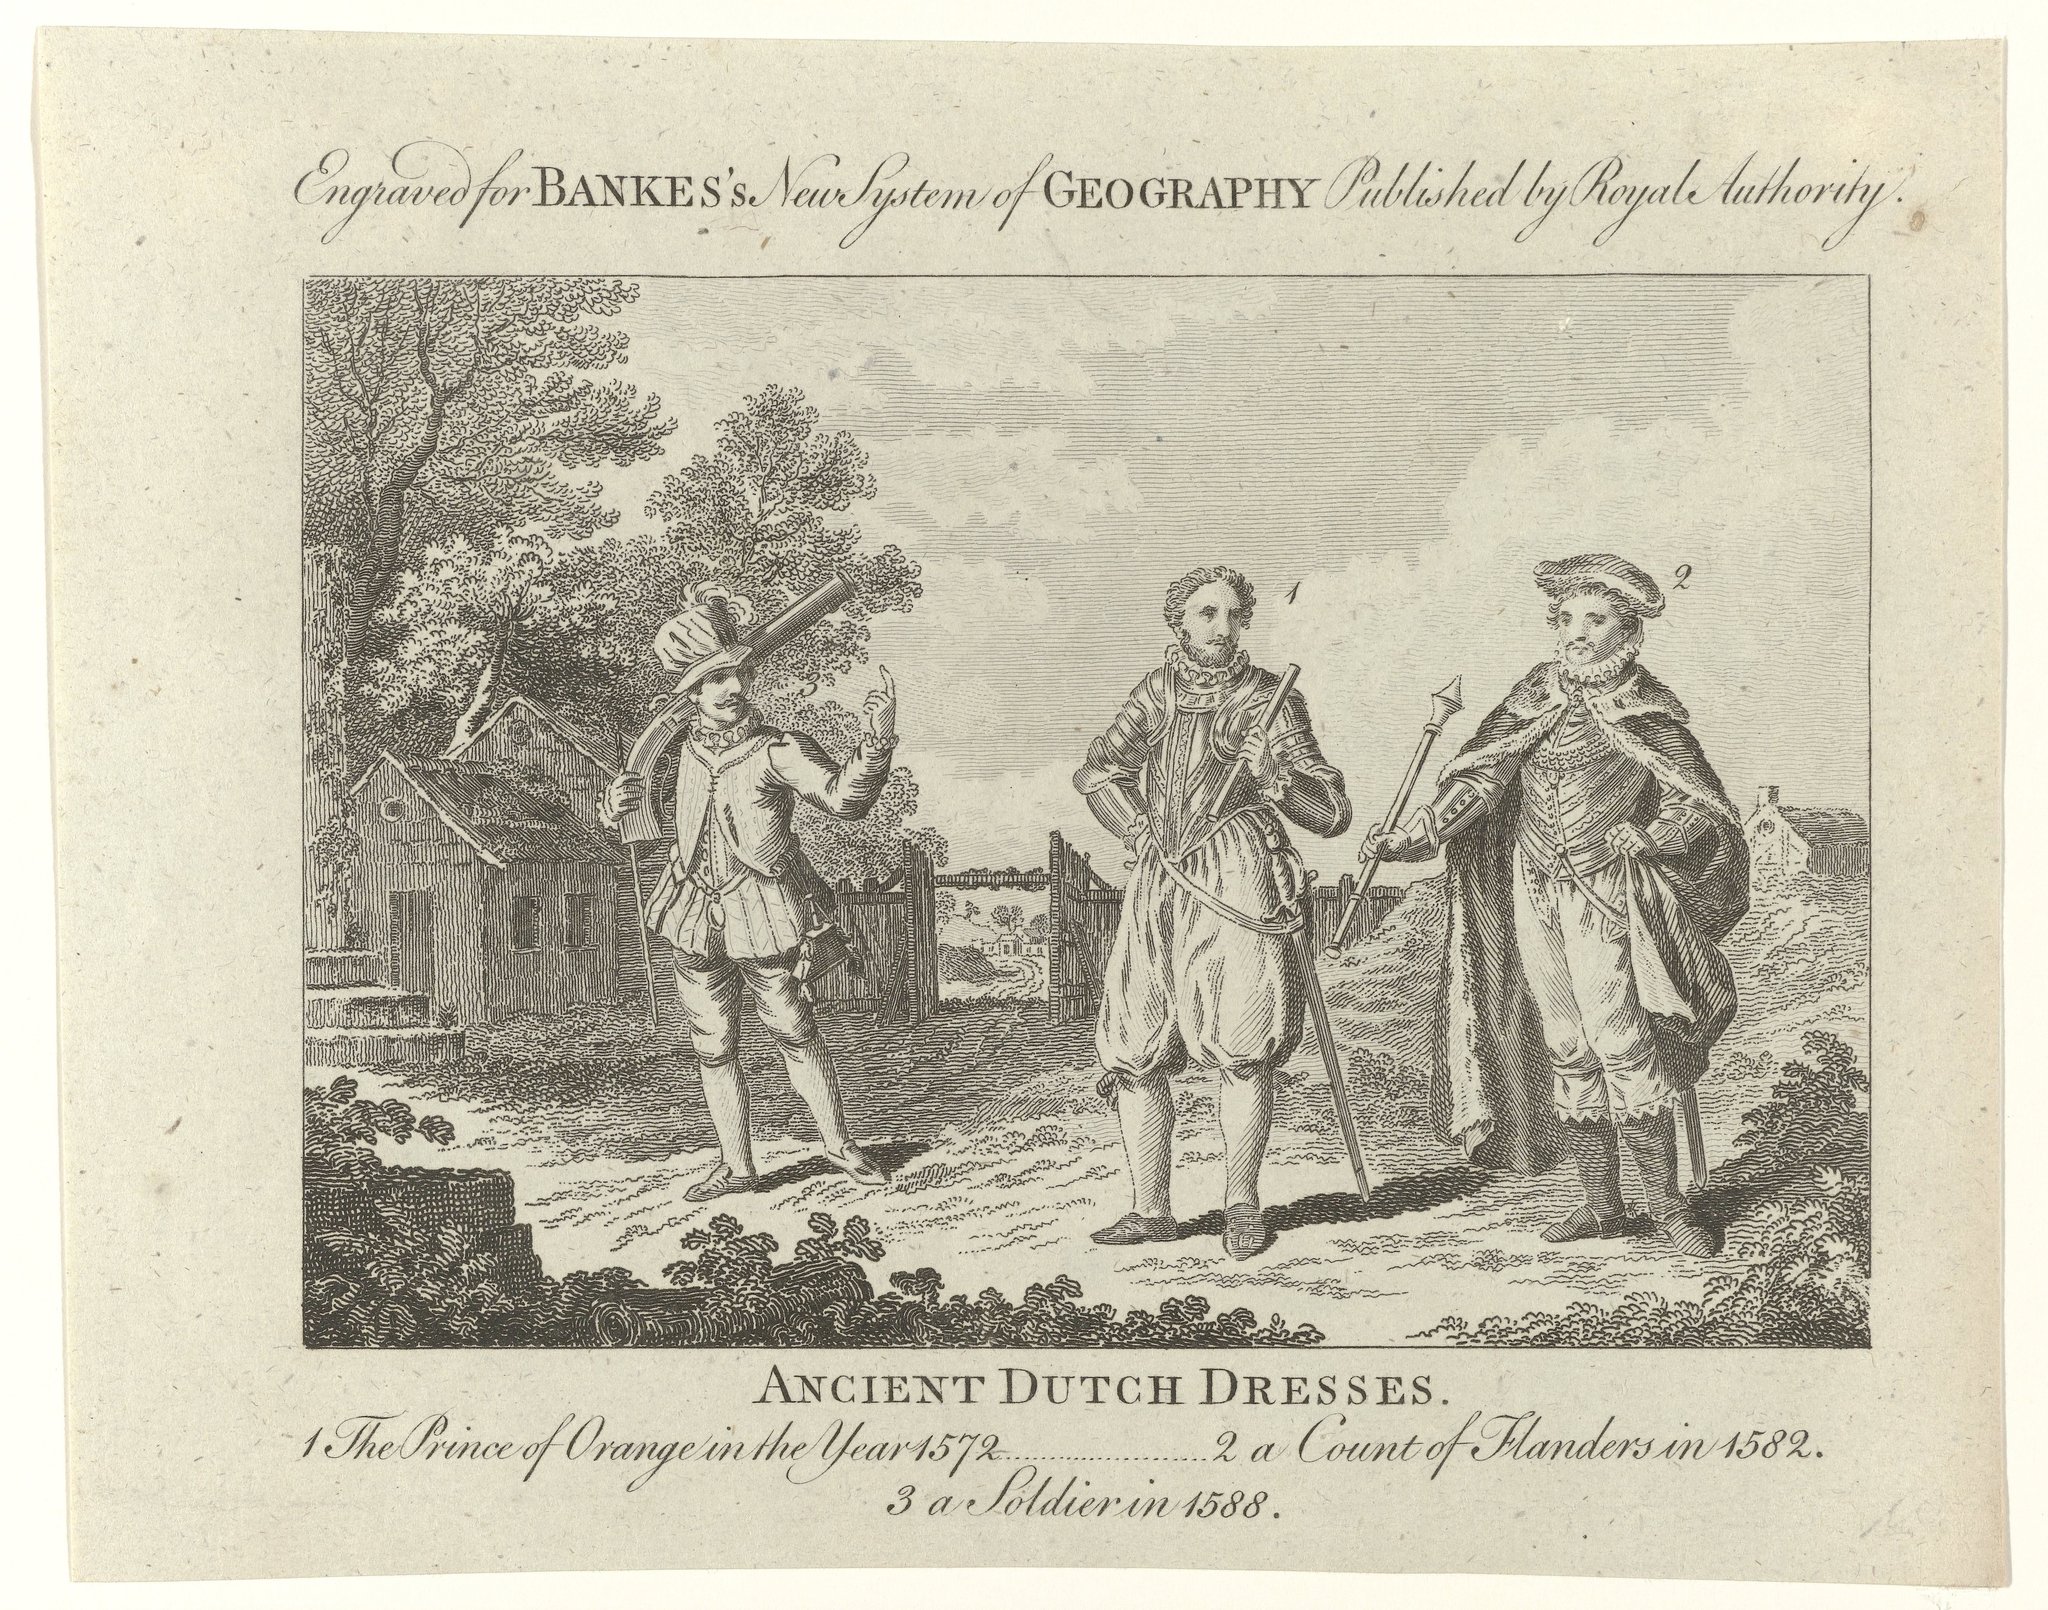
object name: costume print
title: Drie staande mannen in een landschap, gekleed in 16de eeuwse kostuum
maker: charles grignion (i)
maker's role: print maker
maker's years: 1716-1810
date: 1760-1770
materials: paper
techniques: engraving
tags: neck-gear ~ clothing (+ men's clothes), fashion plates, clothing for the upper part of the body (+ men's clothes), trousers, breeches, etc. (breeches) (+ men's clothes)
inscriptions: title: ‘Ancient Dutch Dresses’, inscription: ‘Engraved for Bankes's New System of geography Published by Royale Authority’, caption: ‘1 The Prince of Orange in the Year 1572.....................2 a Count of Flanders in 1582. 3 a Soldier in 1588.’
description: Drie staande mannen in een landschap. Nummer 1 stelt de prins van Oranje in het jaar 1572 voor. Hij draagt een plooikraag, harnas, wijde kniebroek en kousen. Accessoires: staf of rol papier, zwaard, opengewerkte schoenen. Nummer 2 stelt de graaf van Vlaanderen in het jaar 1582 voor. Hij draagt een plooikraag, harnas, mantel afgezet met bont, lange broek en canons. Accessoires: bonnet, scepter, zwaard (?) en (rij)laarzen. Nummer 3 stelt een soldaat in het jaar 1588 voor. Hij draagt een plooikraag, kort wambuis, korte pofbroek met splitten, kniebroek en kousen. Accessoires: hoge hoed of toque met veer, geweer, opengewerkte schoenen.